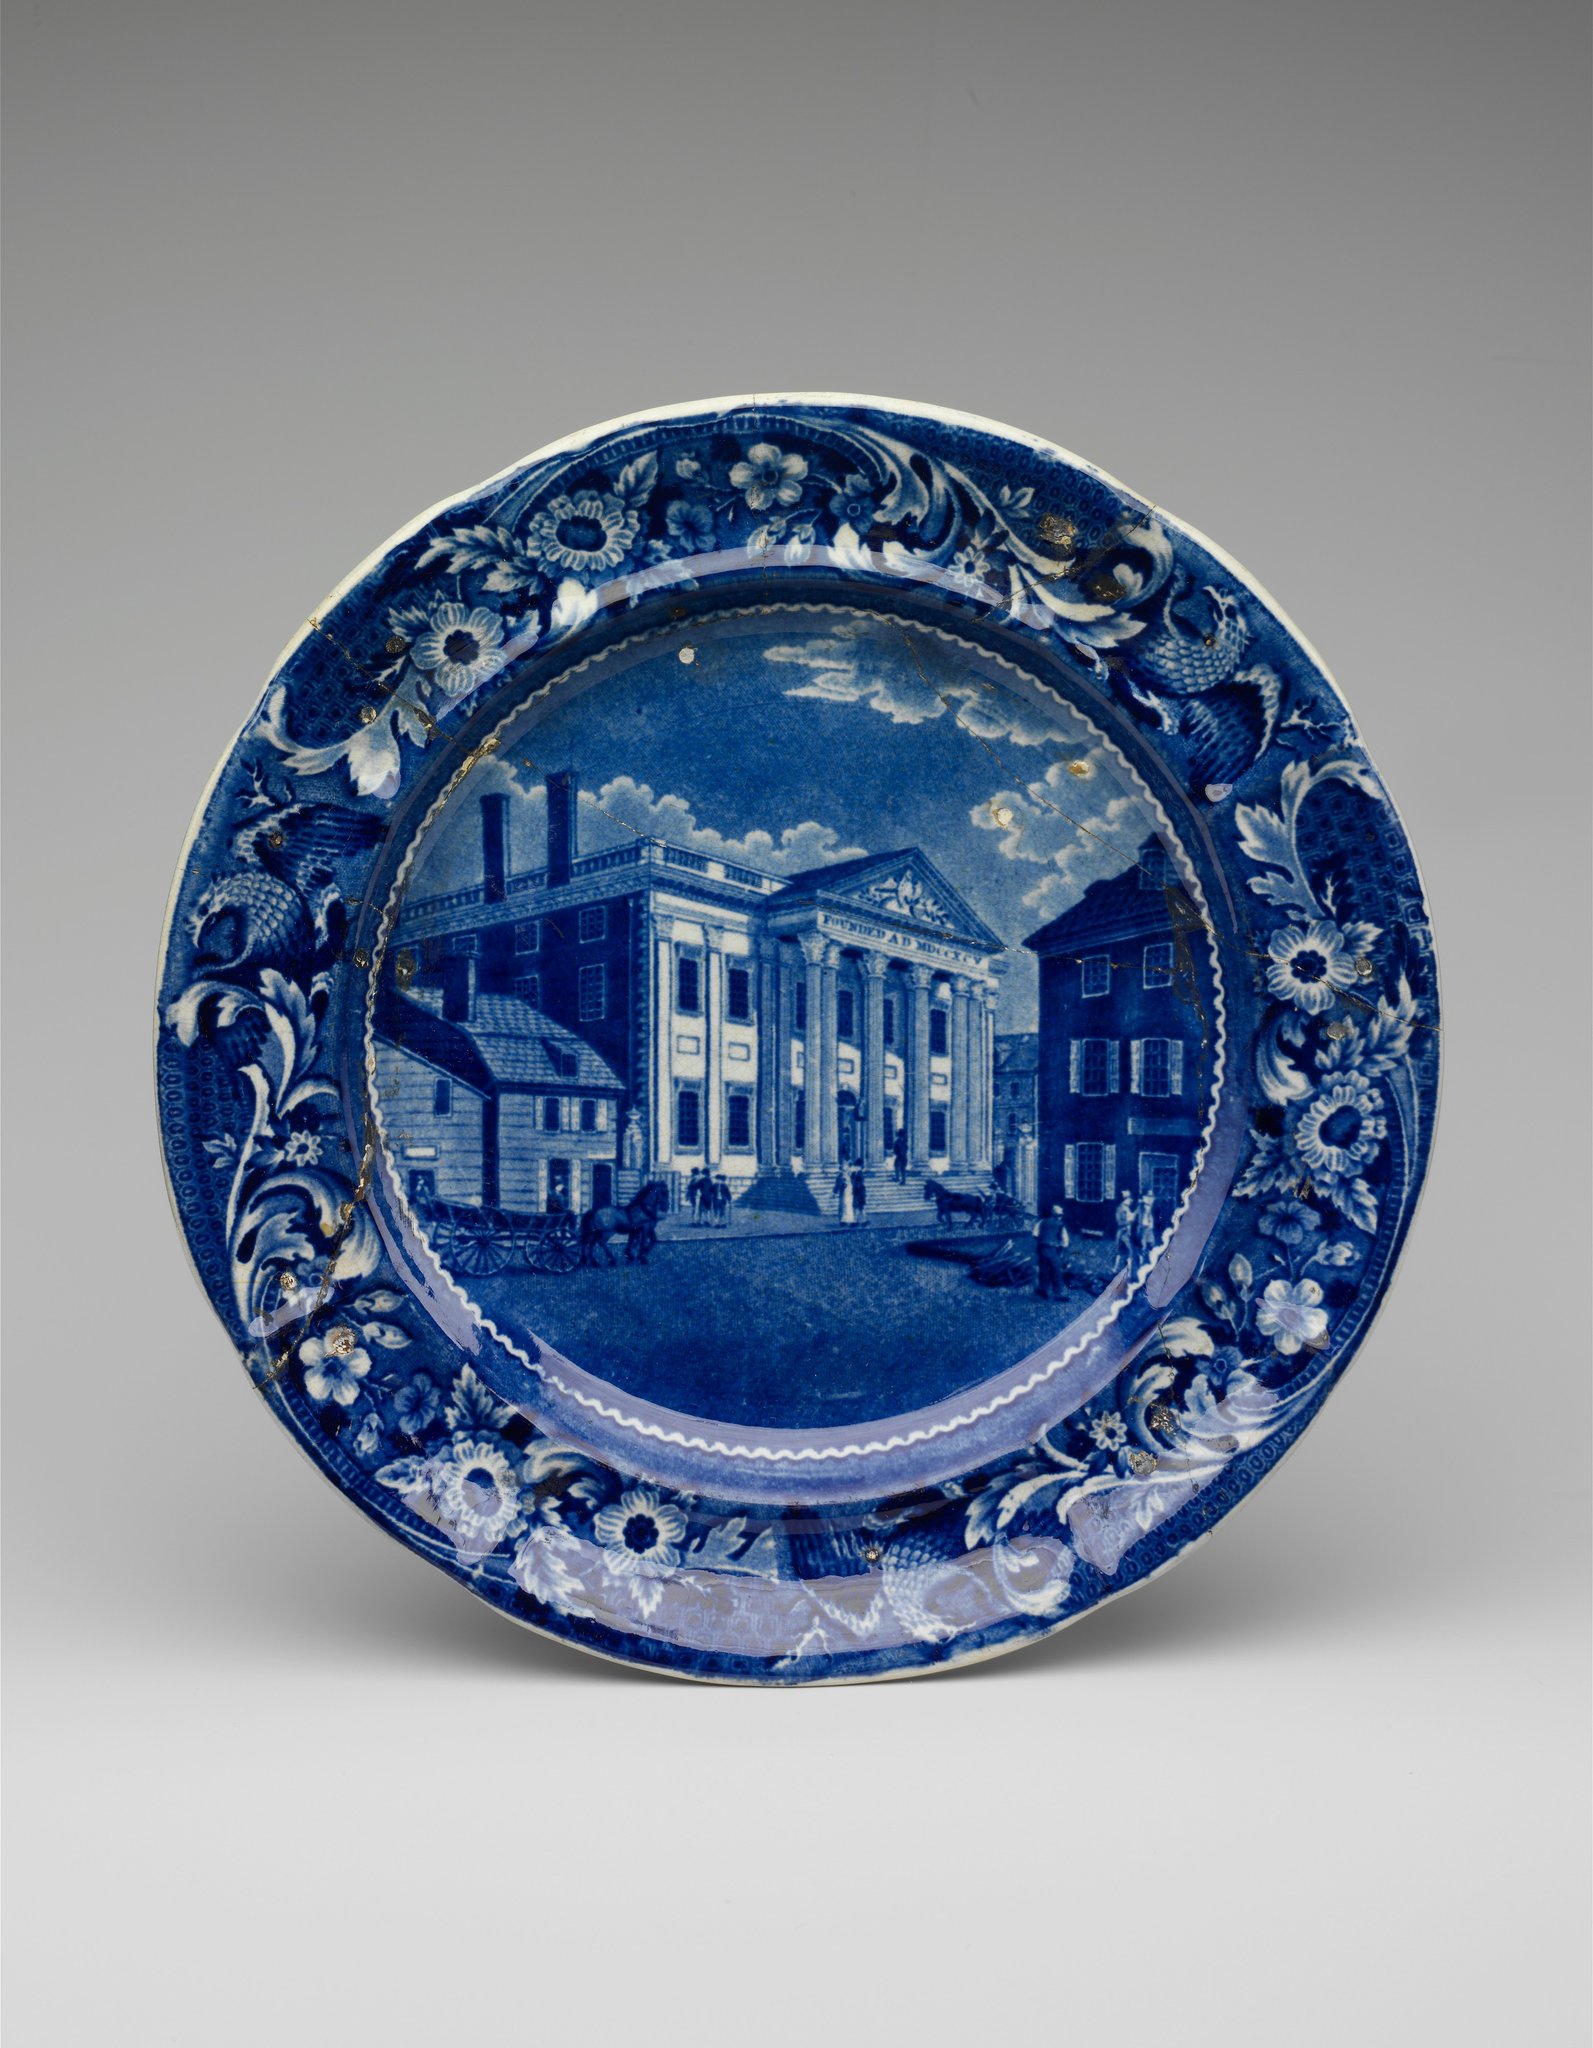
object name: plate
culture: british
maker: joseph stubbs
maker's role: maker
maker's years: 1819-1836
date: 1822-1836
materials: earthenware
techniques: transfer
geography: england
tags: buildings,horses,flowers